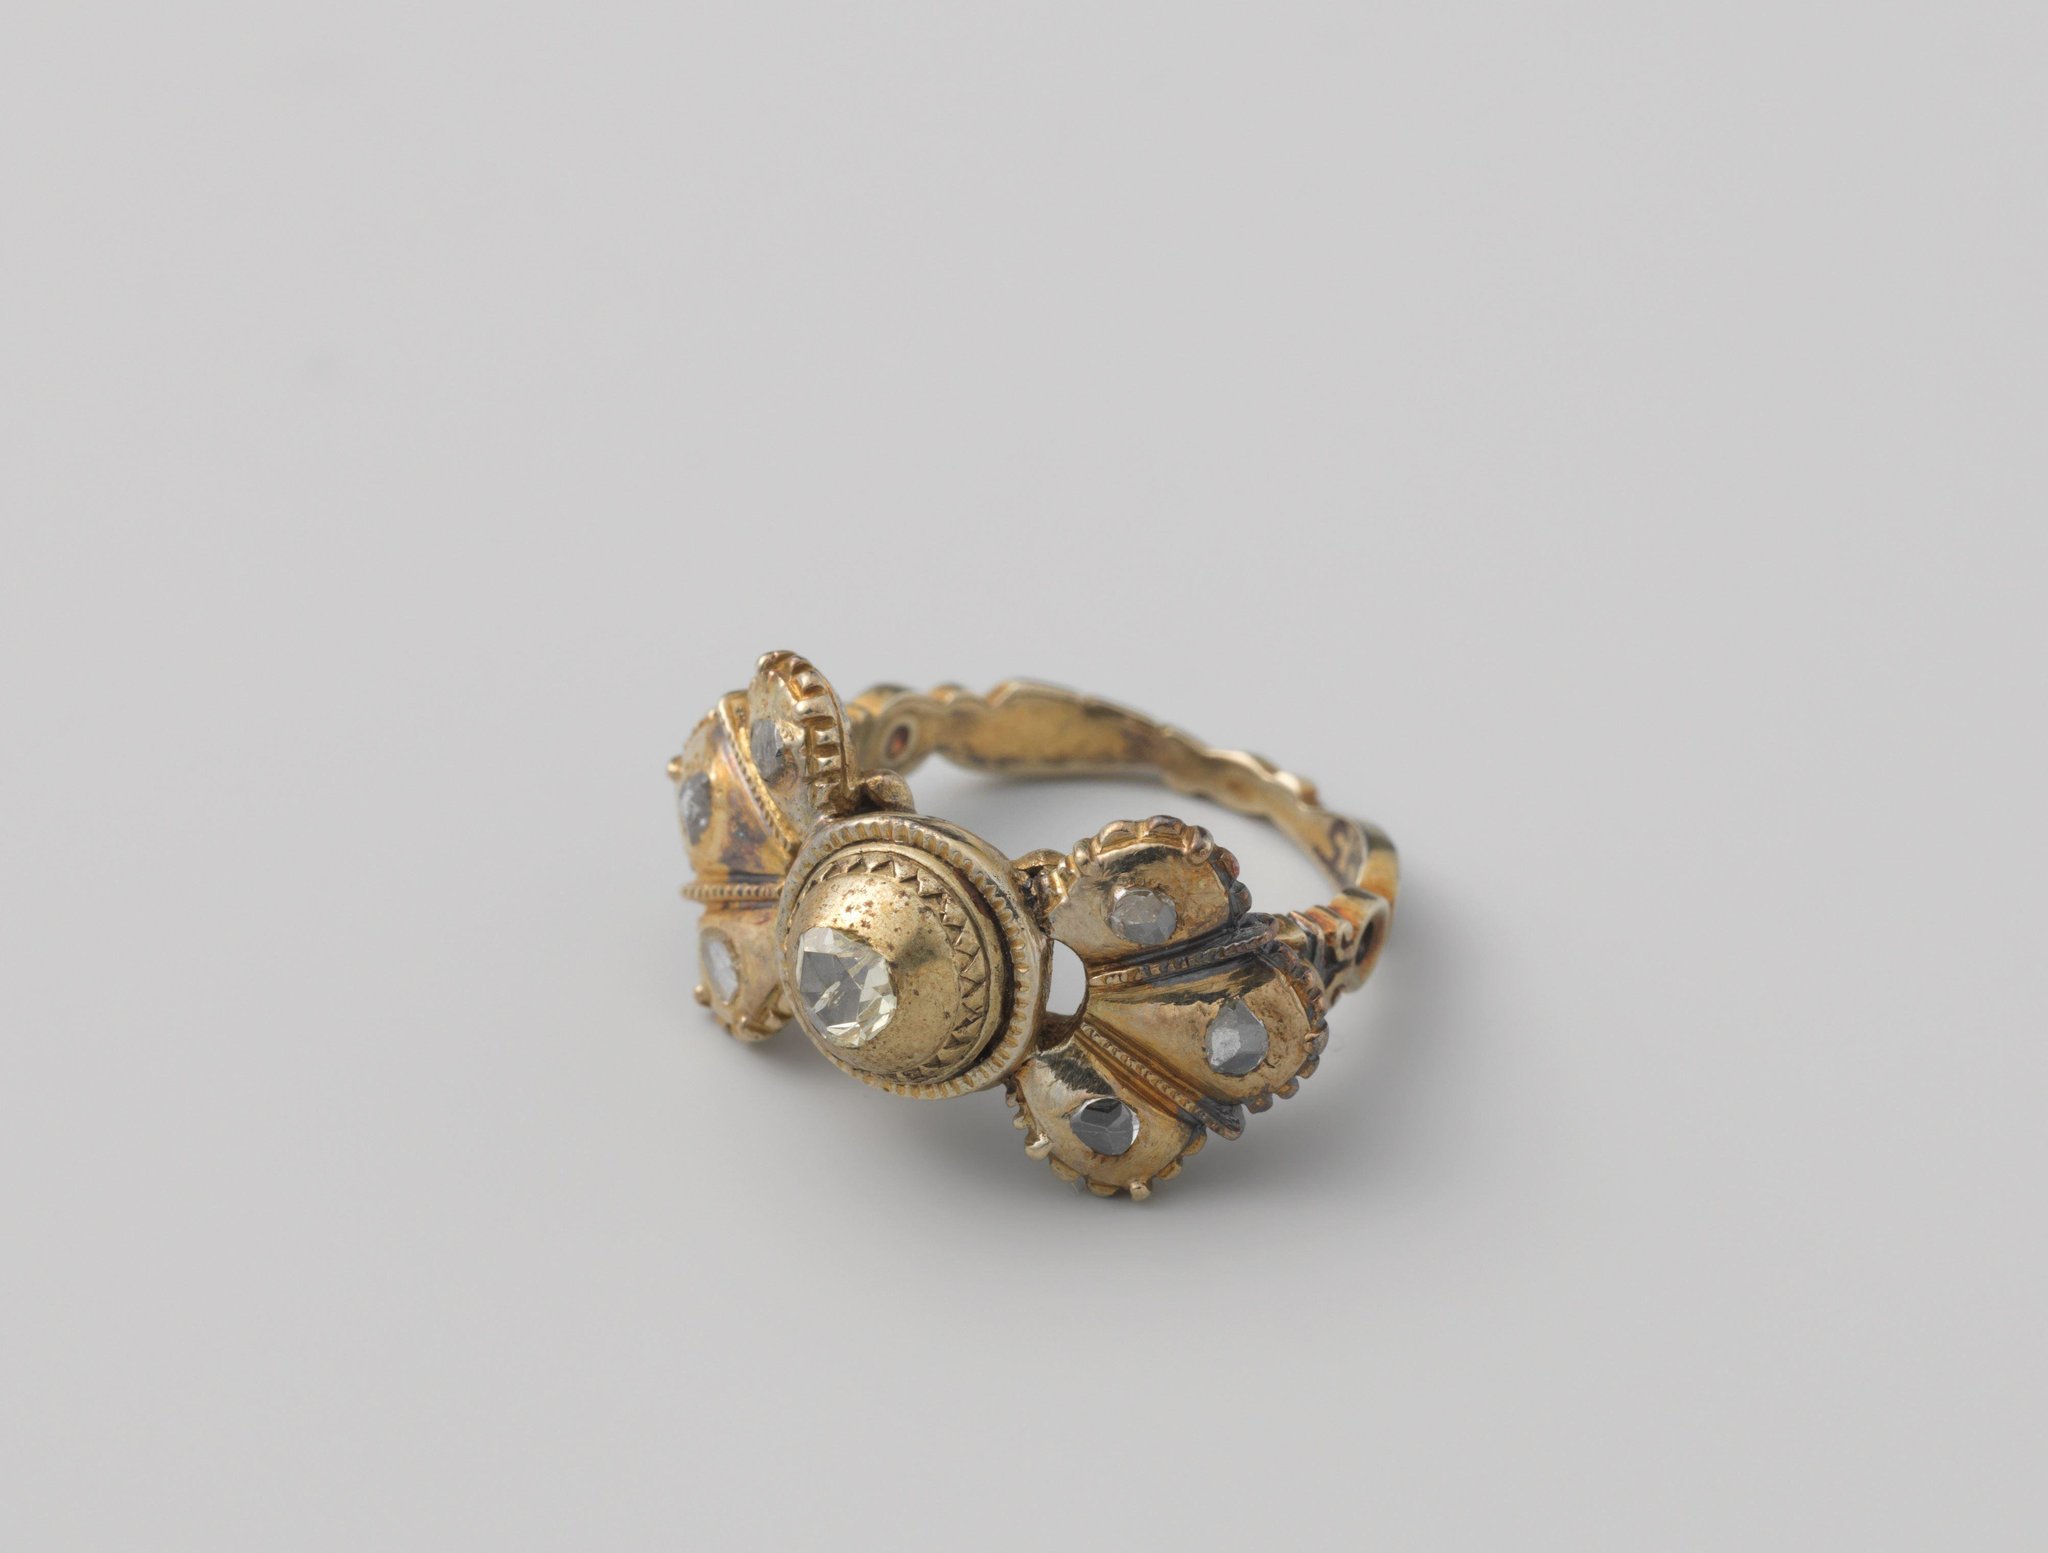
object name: ring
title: Ring van verguld zilver bezet met zeven diamanten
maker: Anonymous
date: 1650-1690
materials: diamond, silver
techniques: gilding, grinding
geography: netherlands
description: Verguld zilveren ring bezet met zeven diamanten in de vorm van een strik. De band of hoep van de ring is opgebouwd uit verschillende ornamenten. De grotere centrale diamant is roosgeslepen (Antwerpse roos) en de zes kleinere diamanten hebben elk drie facetten (drievlak).